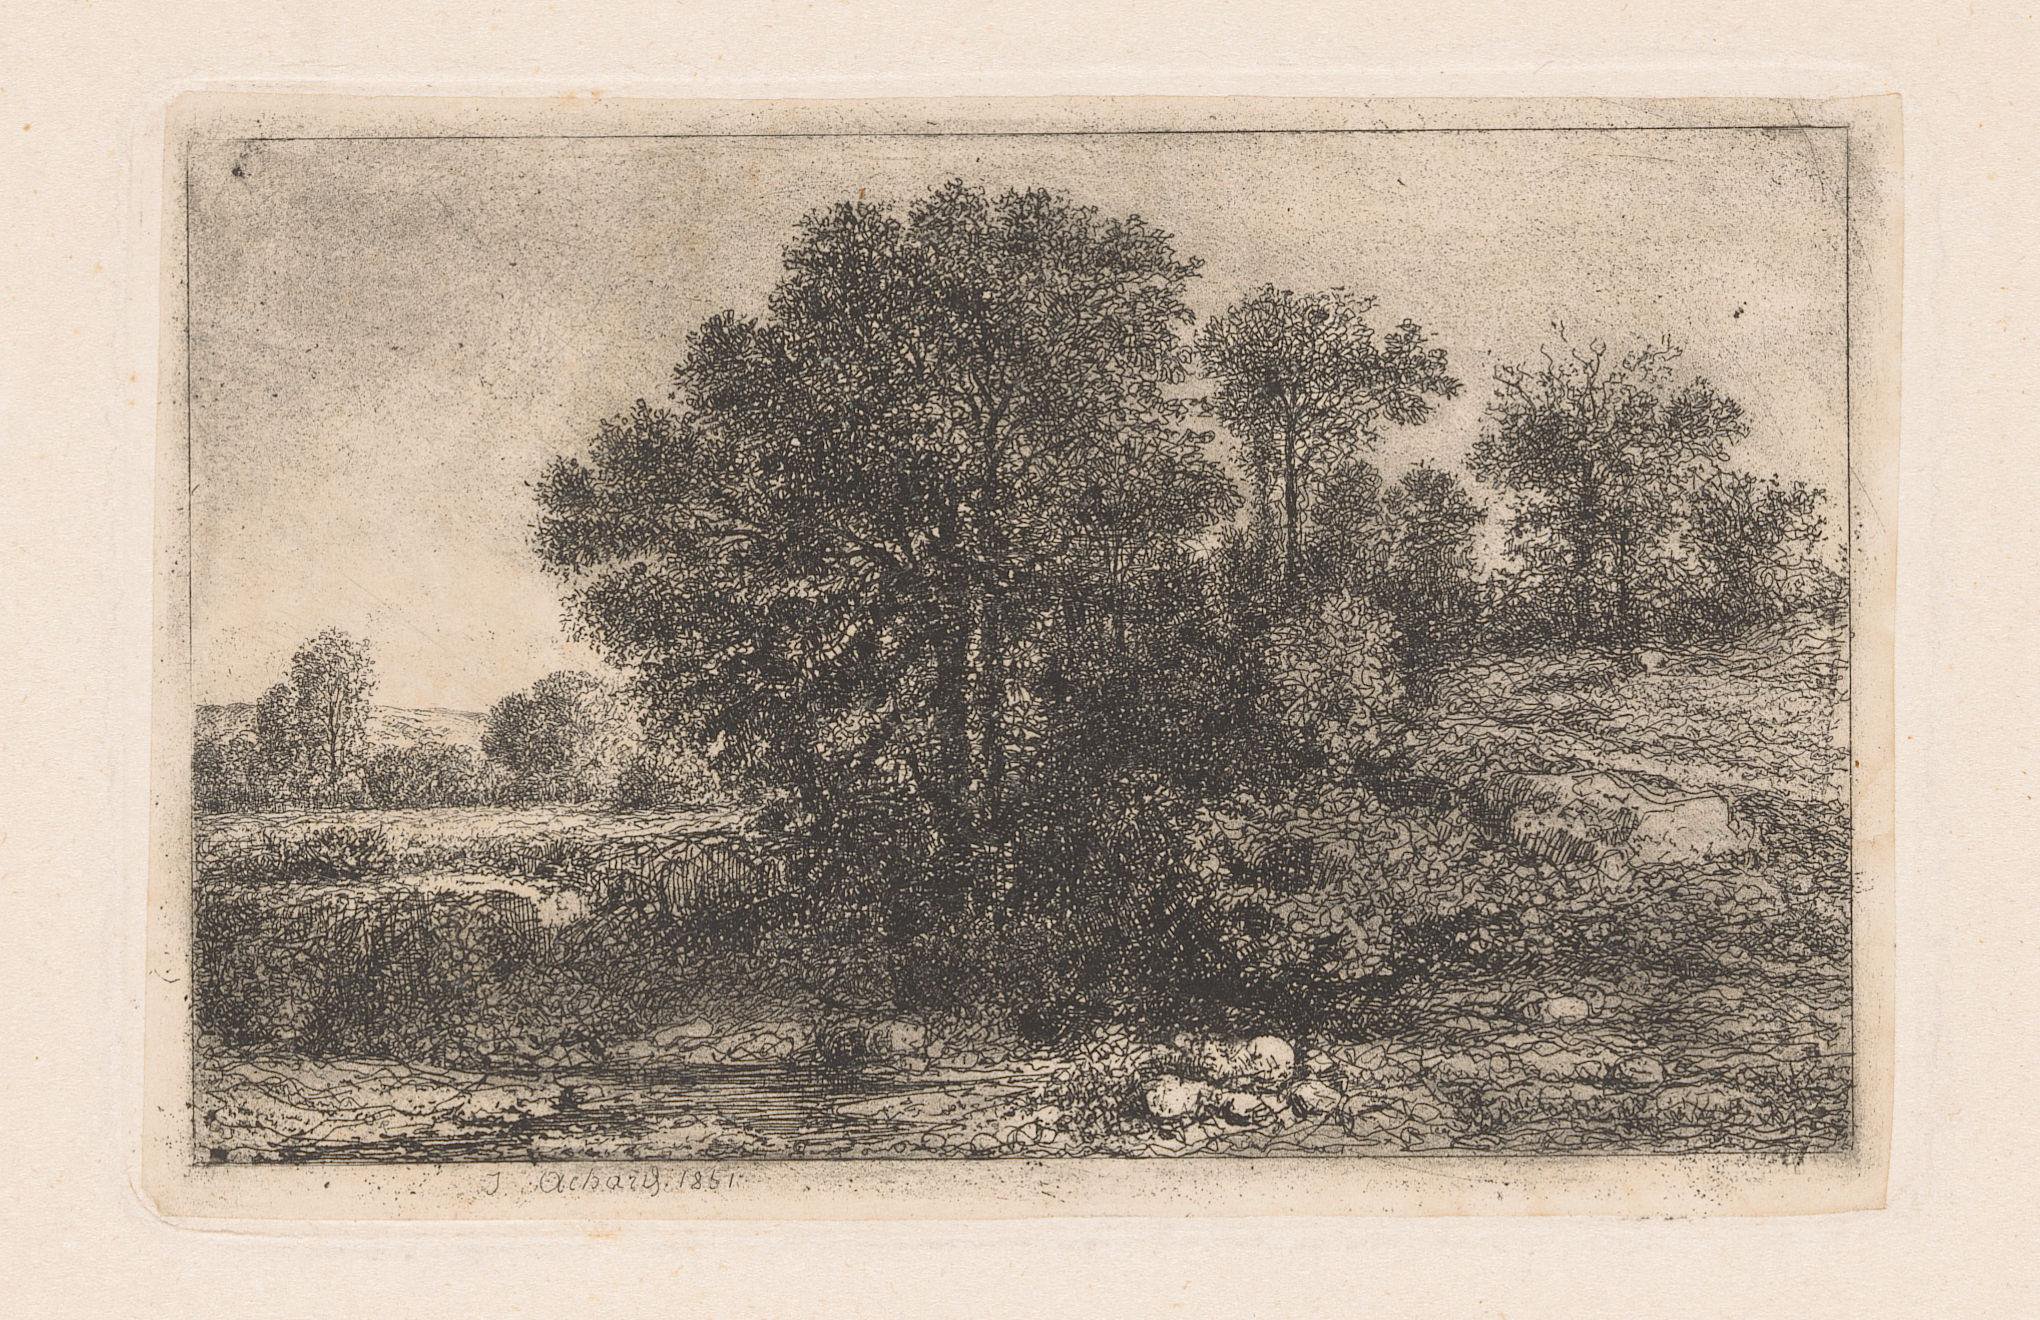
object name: print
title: Bomen tegen een helling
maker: jean alexis achard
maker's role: print maker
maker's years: 1807-1884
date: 1851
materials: paper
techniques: etching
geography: france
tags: trees, mound, verge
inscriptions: inscription: ‘4e état avec le nom’, collector's mark: Lugt 2228